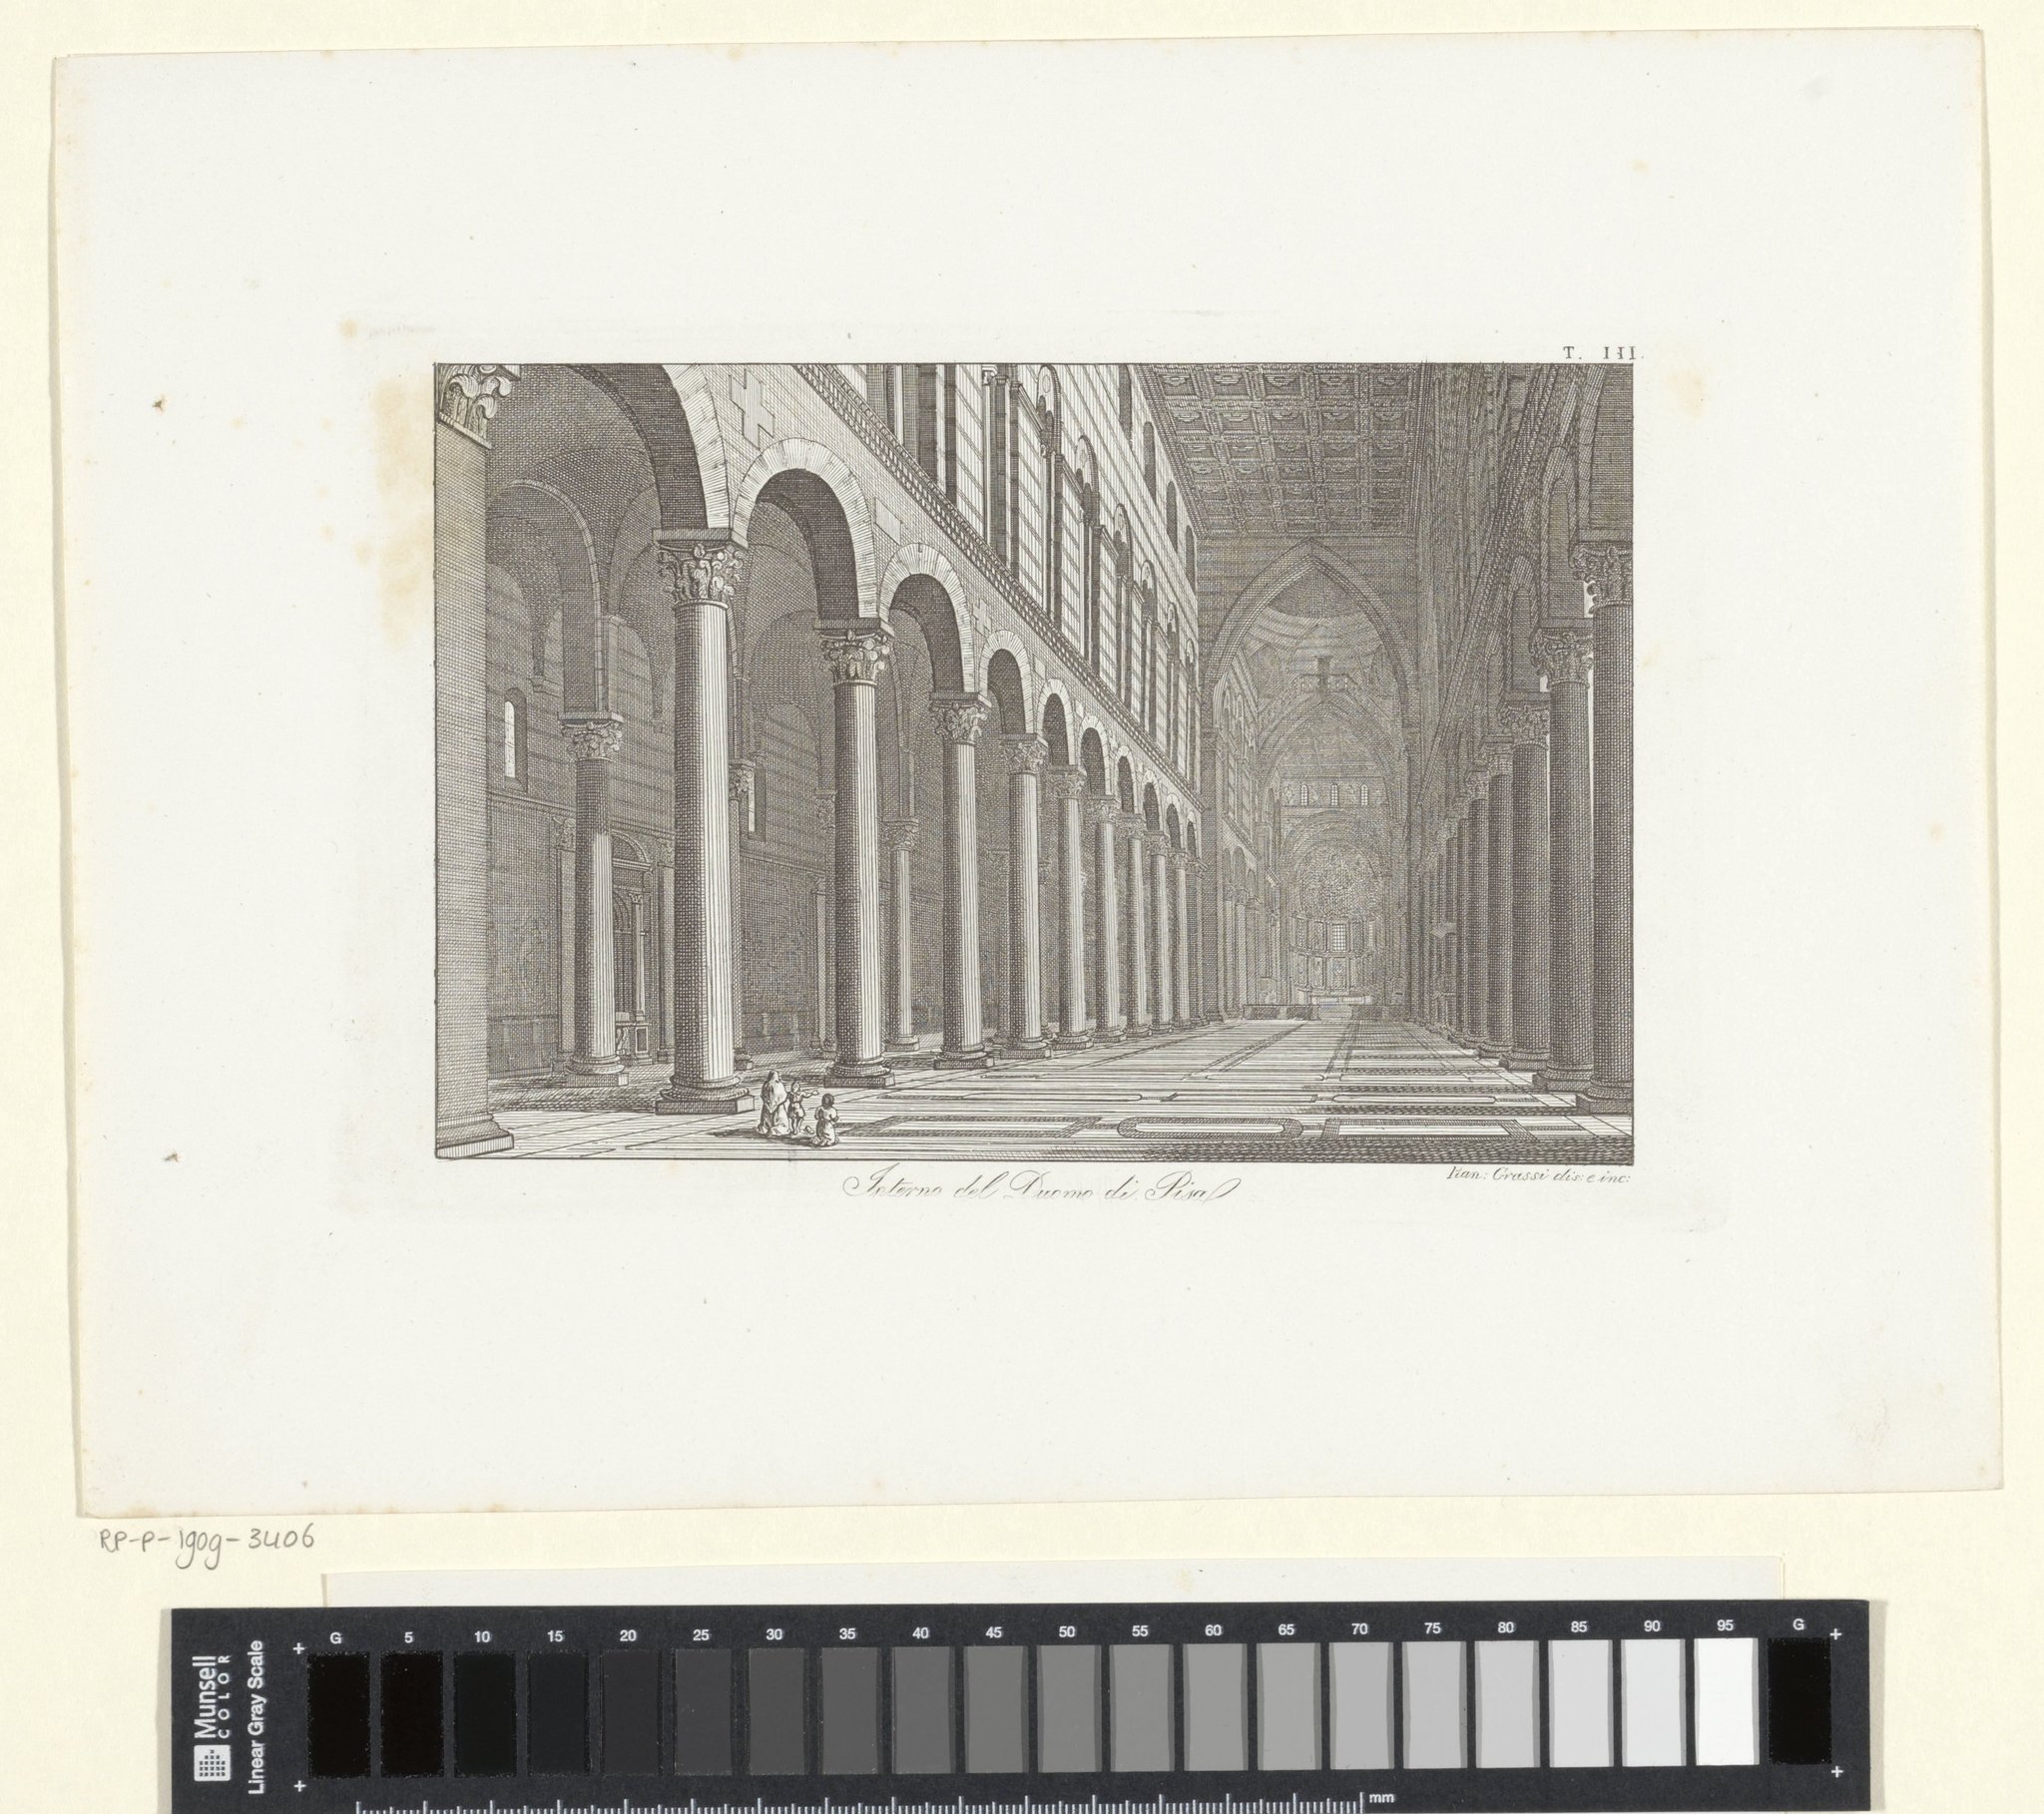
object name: print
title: Interno del Duomo di Pisa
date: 1854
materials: paper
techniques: etching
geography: pisa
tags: parts of church interior: nave, interior of church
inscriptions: collector's mark: Lugt 2228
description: Gezicht in de Dom van Pisa (Duomo di Pisa). Genummerd rechtsboven: T. III.